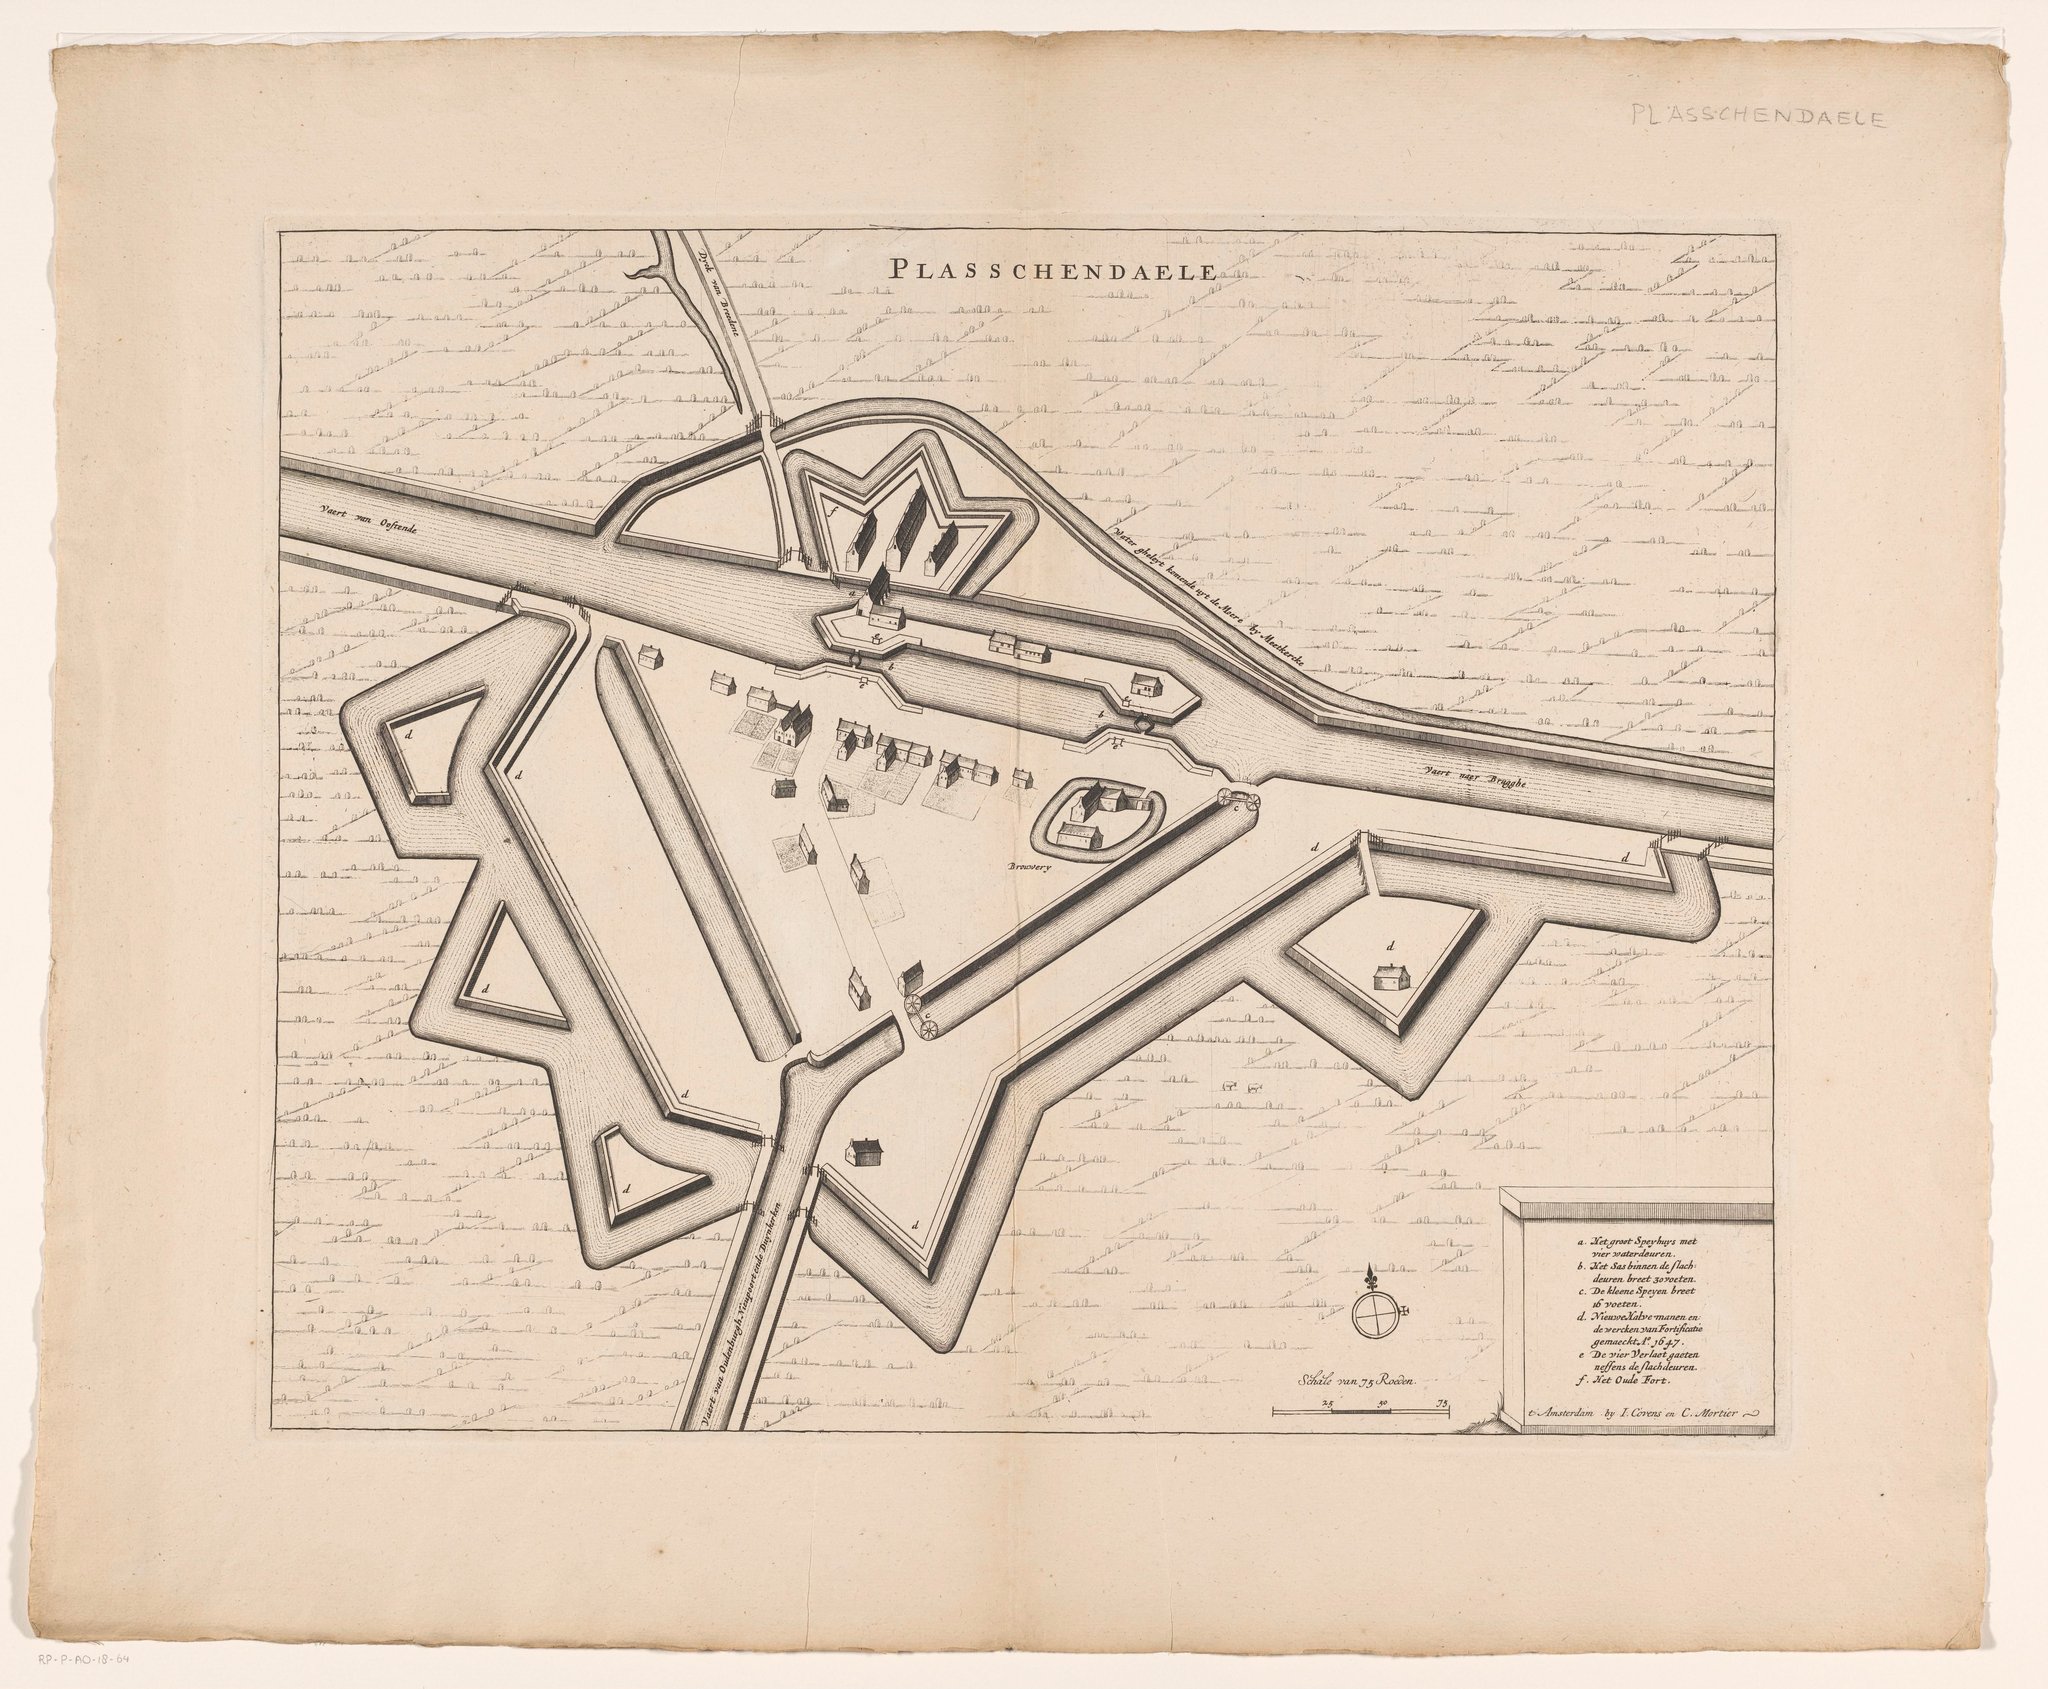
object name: area plan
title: Plattegrond van Plassendale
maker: Anonymous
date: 1698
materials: paper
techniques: engraving, etching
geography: amsterdam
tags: maps of cities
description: Plattegrond van Plassendale met gebouwen in vogelvluchtperspectief. Door Plassendale heen loopt het kanaal Brugge-Oostende, waarlangs men van het binnenland van Gent naar Oostende kon varen. Boven, in het midden, de titel. Rechtsonder een cartouche met legenda a-f. Links hiervan een schaalstok: Schale van 75 Roeden.